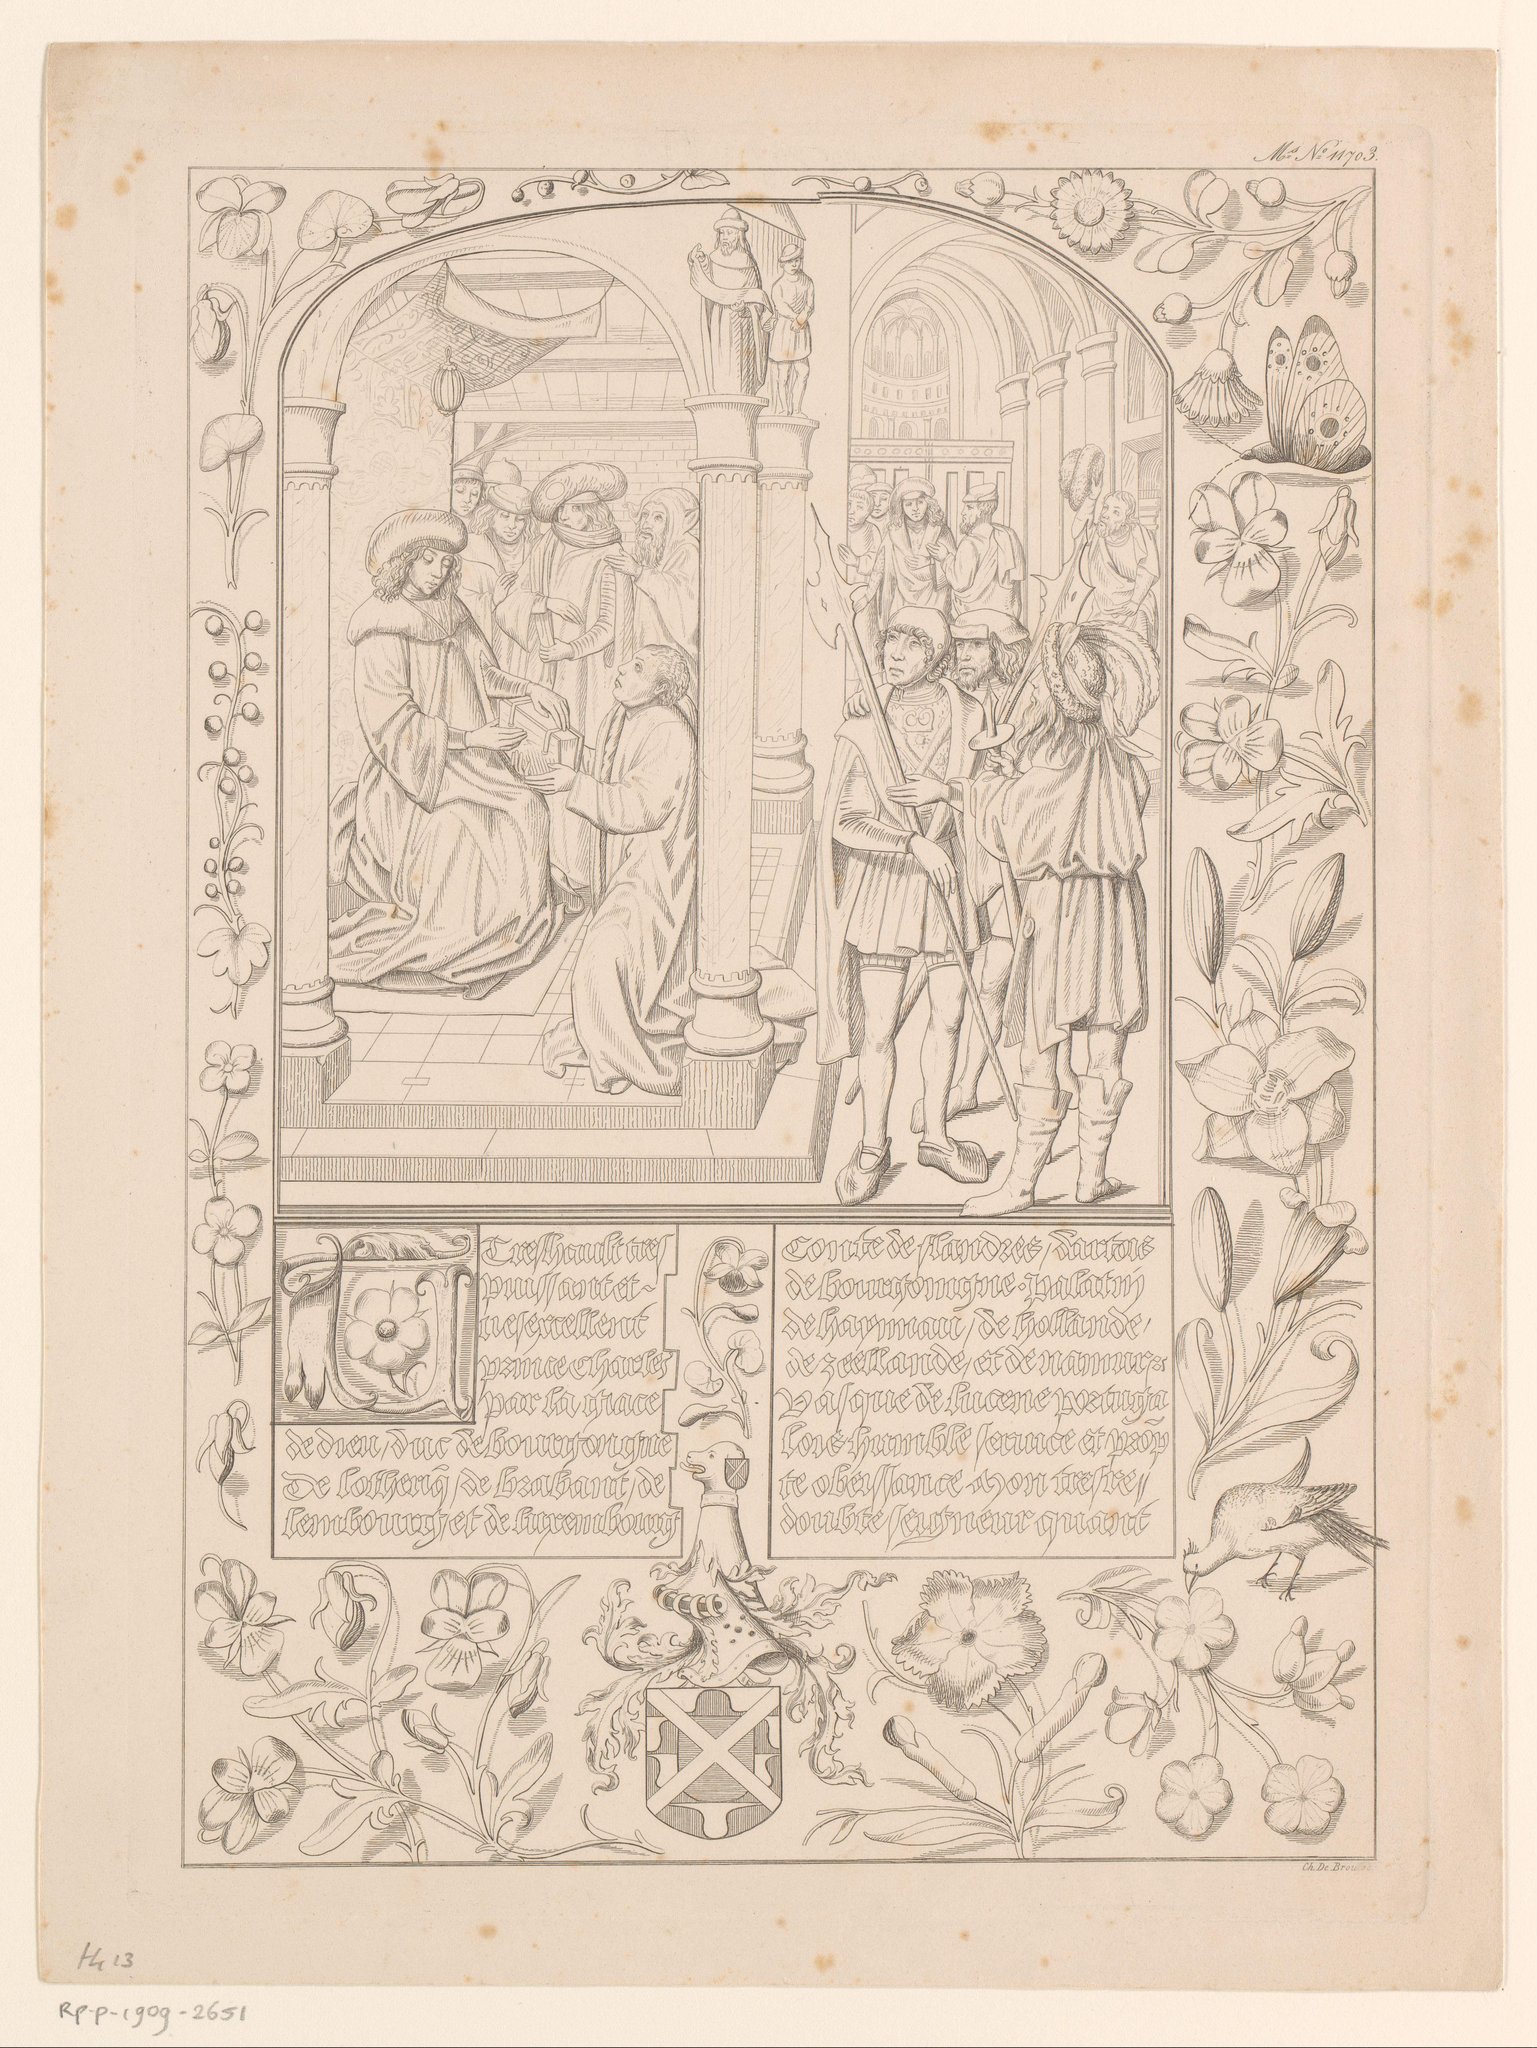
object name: print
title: Reproductie van de titelpagina voor het werk Xenophon van Karel de Stoute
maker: charles de brou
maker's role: print maker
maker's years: 1811-1877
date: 1821-1877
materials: paper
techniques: etching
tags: earl, charles the bold (duke of burgundy), book, the soldier; the soldier's life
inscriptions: collector's mark: Lugt 1485, collector's mark: Lugt 2228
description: Reproductie van de titelpagina voor het werk Xenophon van Karel de Stoute. Een man rijkt een boek aan, aan een andere man. Onder de afbeelding tekst in het Latijn. Rondom een ornamenteel kader met plantmotieven. Midden onder een wapenschild.